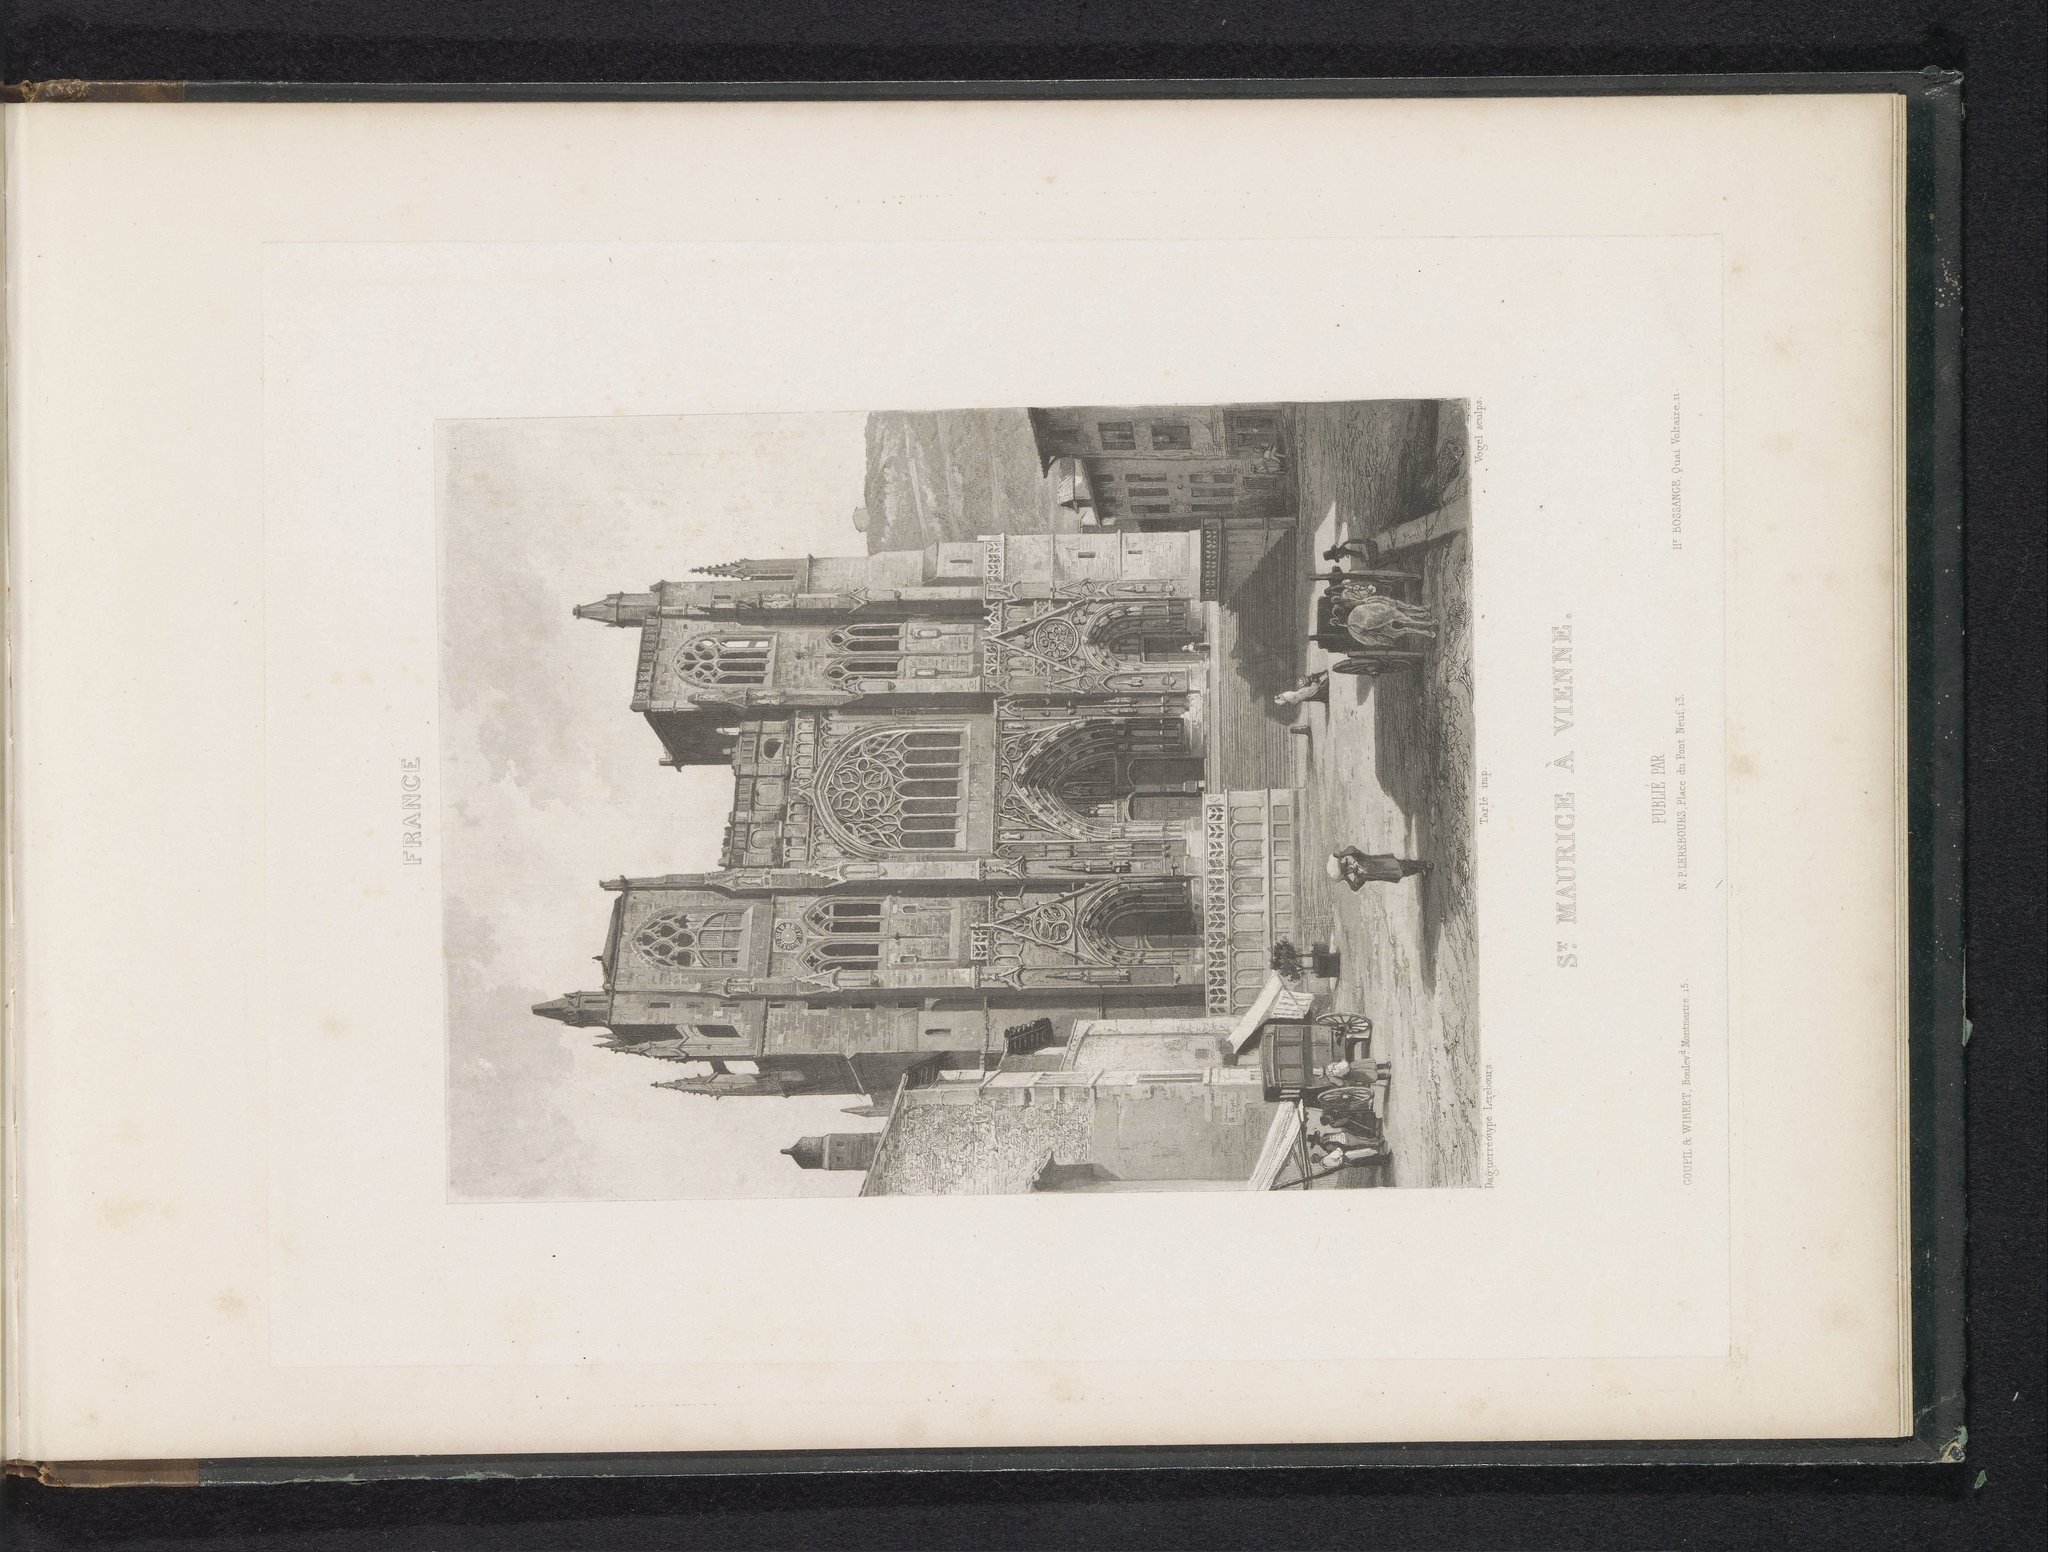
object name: print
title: Gezicht op de Kathedraal van Vienne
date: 1839-1841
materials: paper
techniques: aquatint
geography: paris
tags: church (exterior), façade (of house or building)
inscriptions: inscription: ‘N.P. Lerebours Place du Pont Neuf 15’, inscription: ‘Rittner & Goupil Boulevd Montmartre 15’, inscription: ‘Hr. Bossance Quai Voltaire 11’